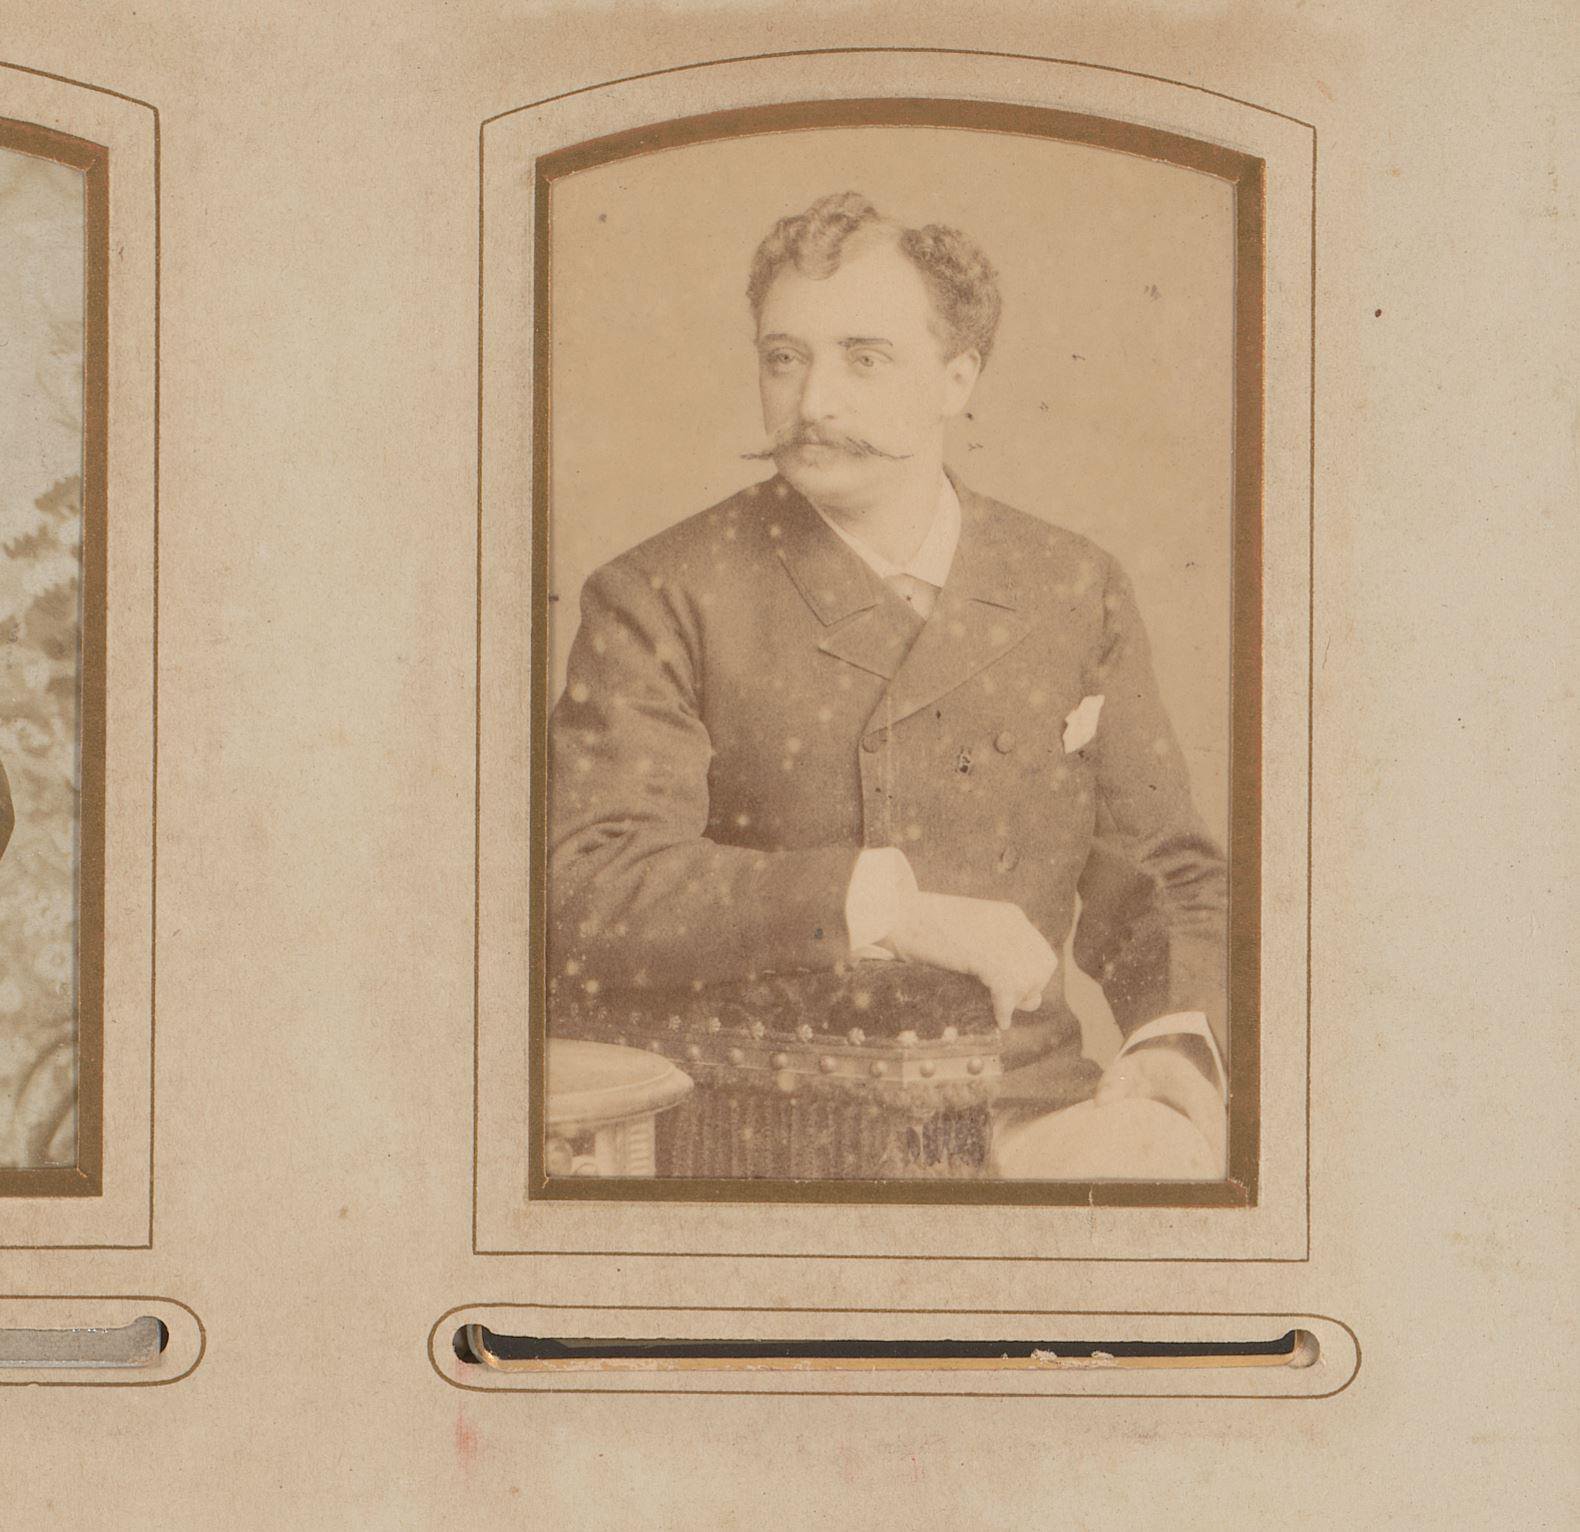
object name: album leaf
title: Portret van een zittende man met snor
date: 1884-1887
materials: cardboard, photographic support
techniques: albumen print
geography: surabaya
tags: sitting figure, moustache, historical persons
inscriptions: inscription: ‘Photographie Instantanée/ Charls & van Es/ Soerabaia./ Specialiteit in Vergrootingen.’